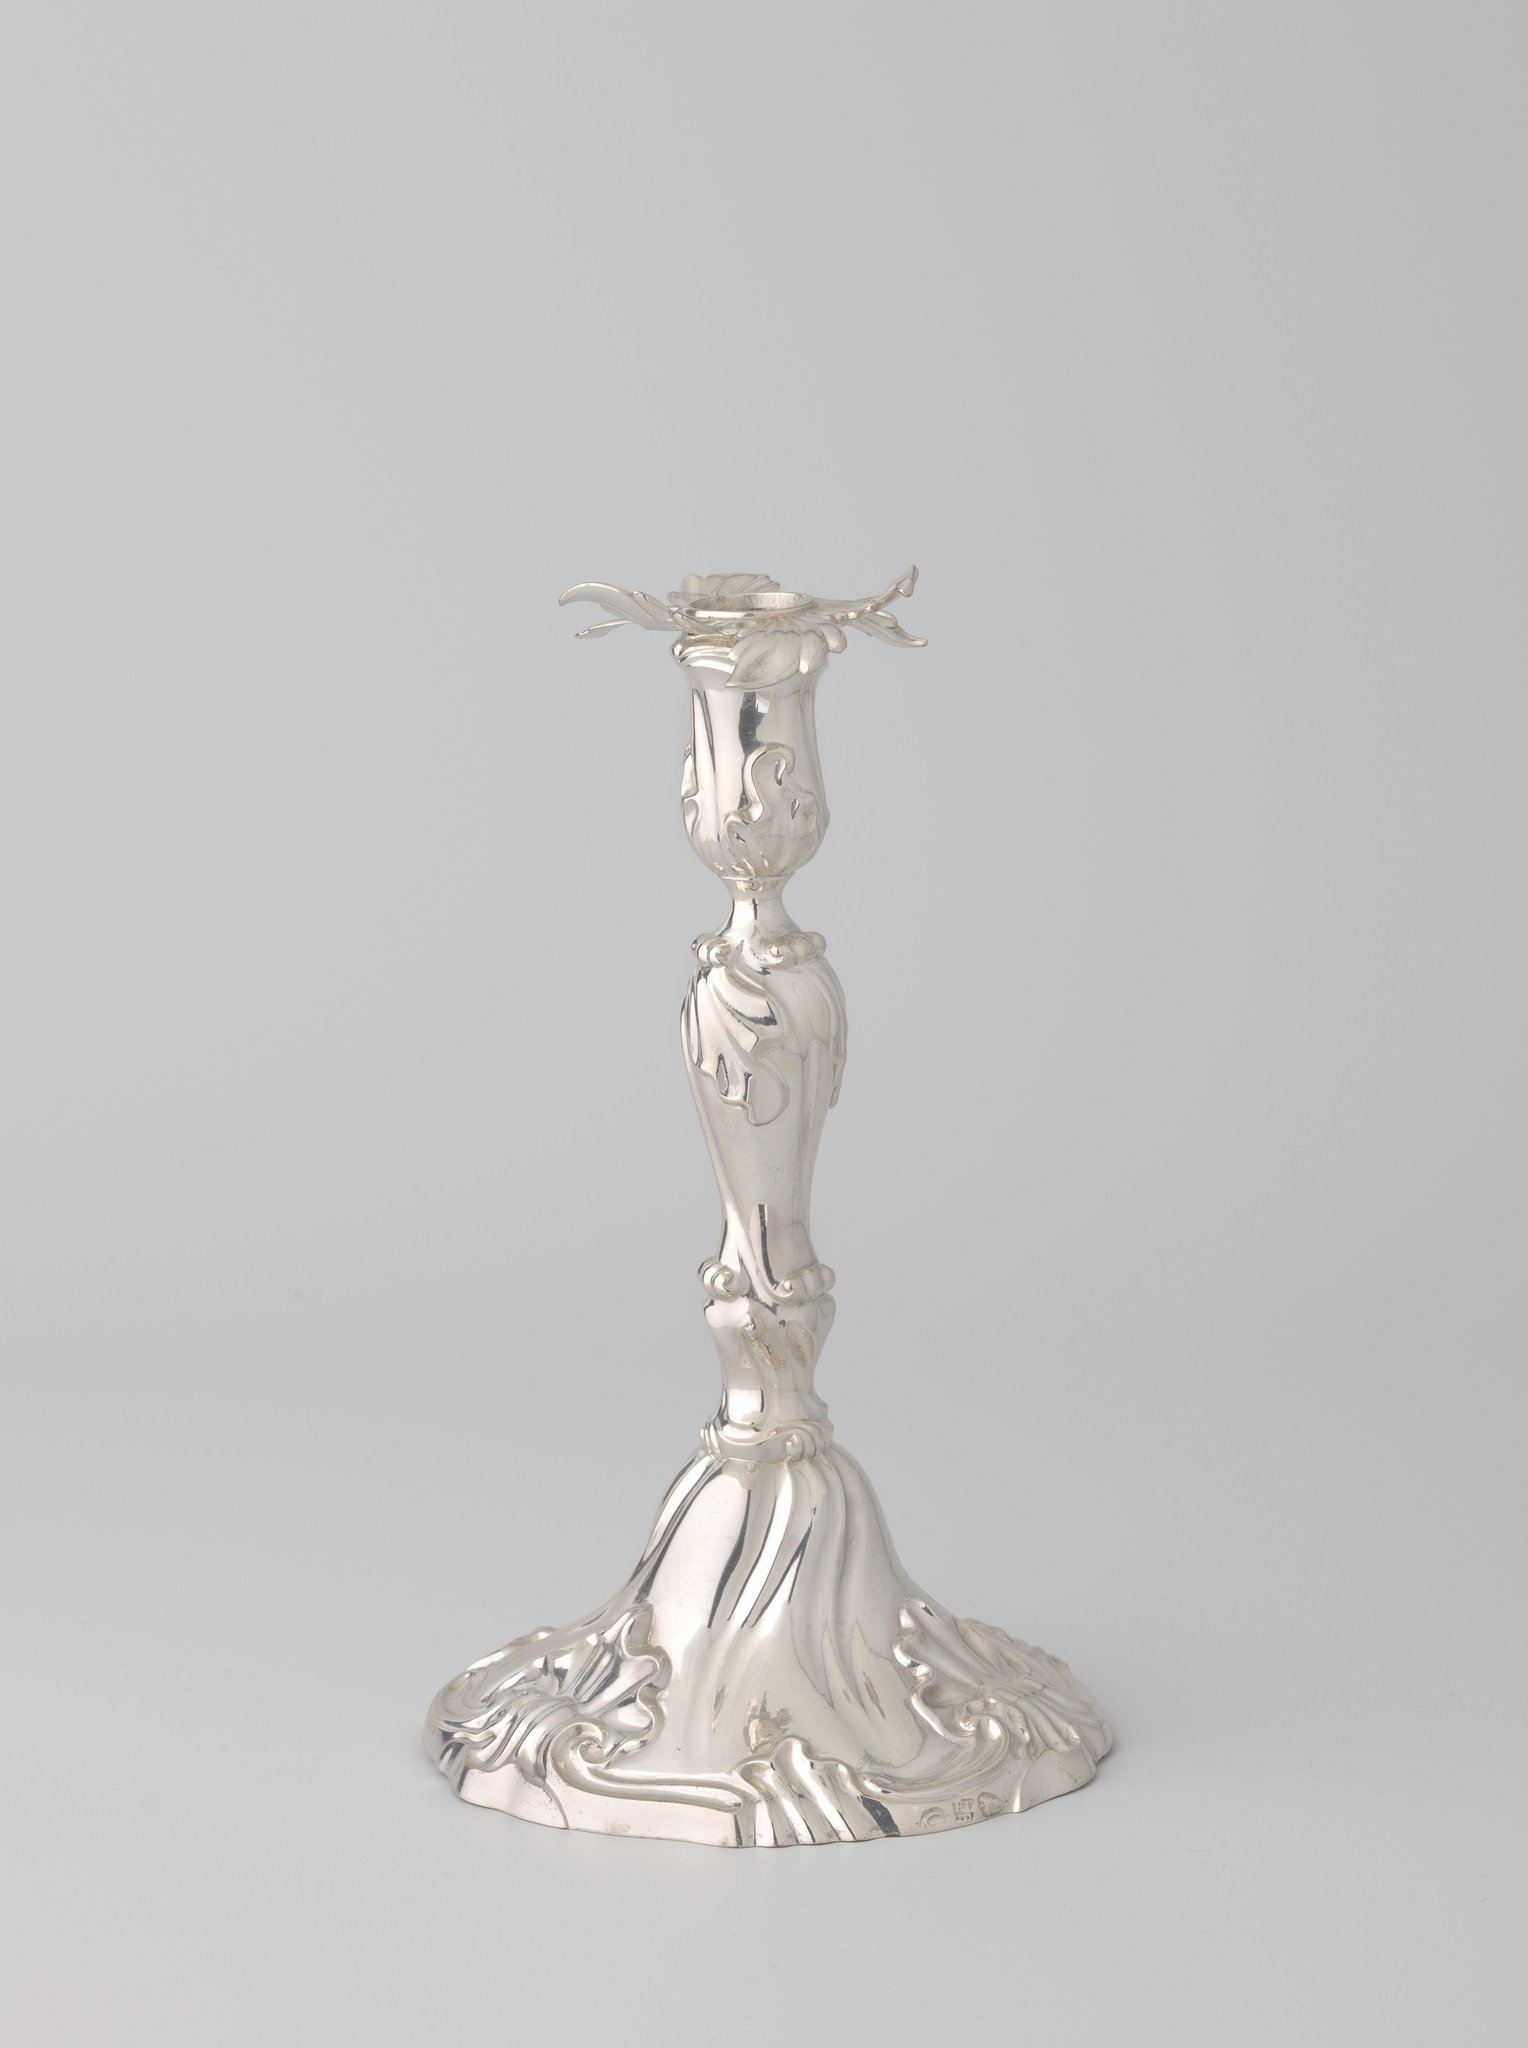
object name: candlestick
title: Kandelaar van zilver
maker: cornelius wilhelmus rensing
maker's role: silversmith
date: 1770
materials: silver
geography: zwolle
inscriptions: mark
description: Wine cooler. Silver. Den Haag, 1768, by Gregorius van der Toorn. Given by the Commissie voor Fotoverkoop and the Vereniging Rembrandt, 1974. Four candlesticks. Silver. Zwolle, 1770, by Cornelis Wilhelmus Rensing. Given by Count J.A.Z. van Rechteren Limpurg, 1937. Castor. Silver. Den Haag, 1768, by Pieter Kersbergen.